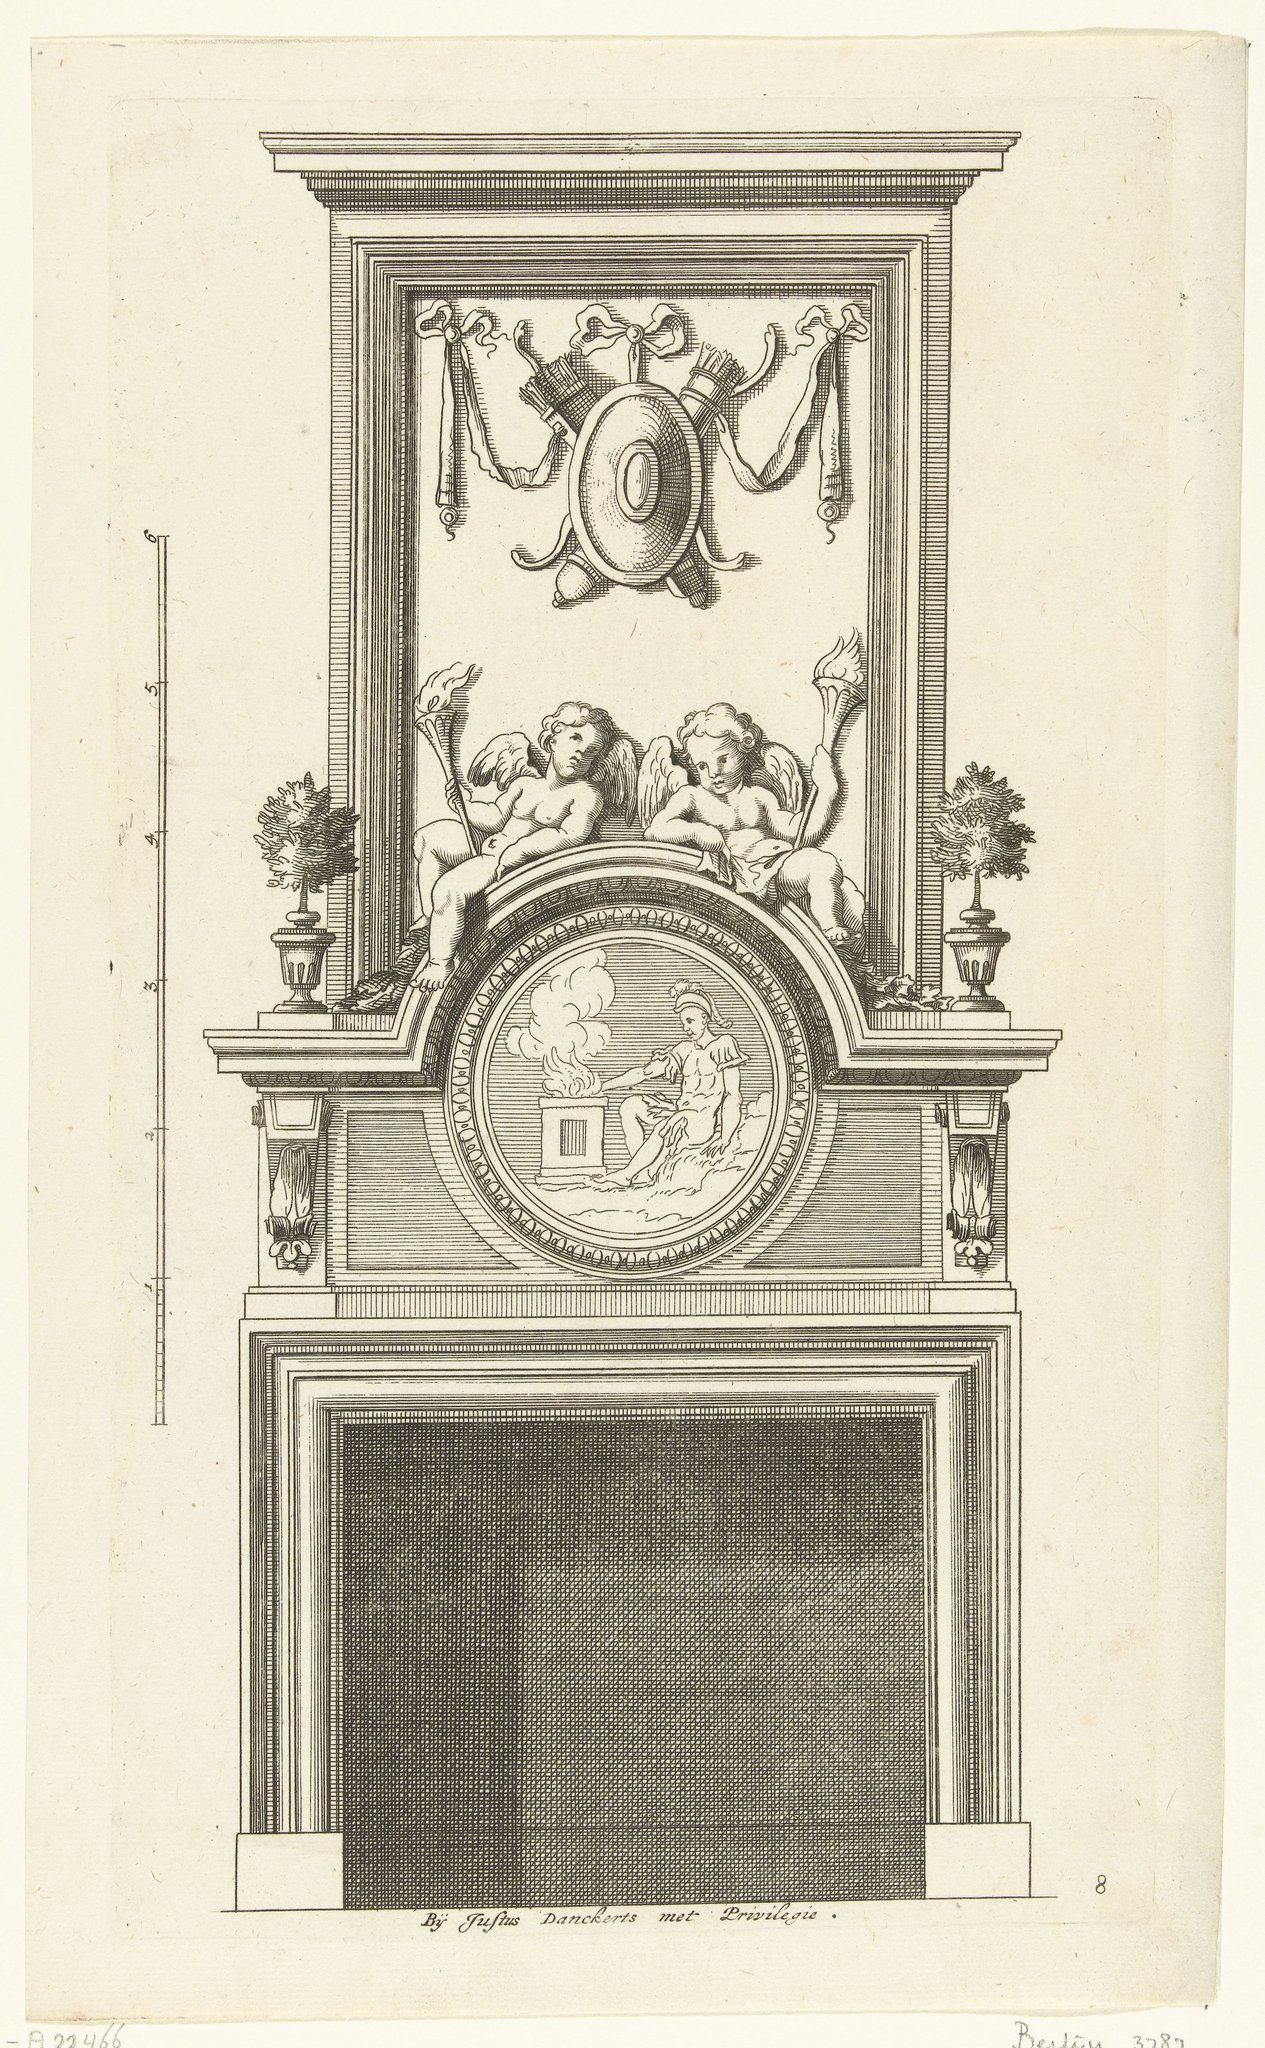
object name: ornament print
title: Onderboezem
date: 1675-1686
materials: paper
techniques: etching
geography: netherlands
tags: chimney-piece, mantelpiece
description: De kroonlijst van het fries boven het tablet wordt onderbroken door een rond medaillon met een offerscène. Daarboven zitten twee putti met een brandende fakkel.